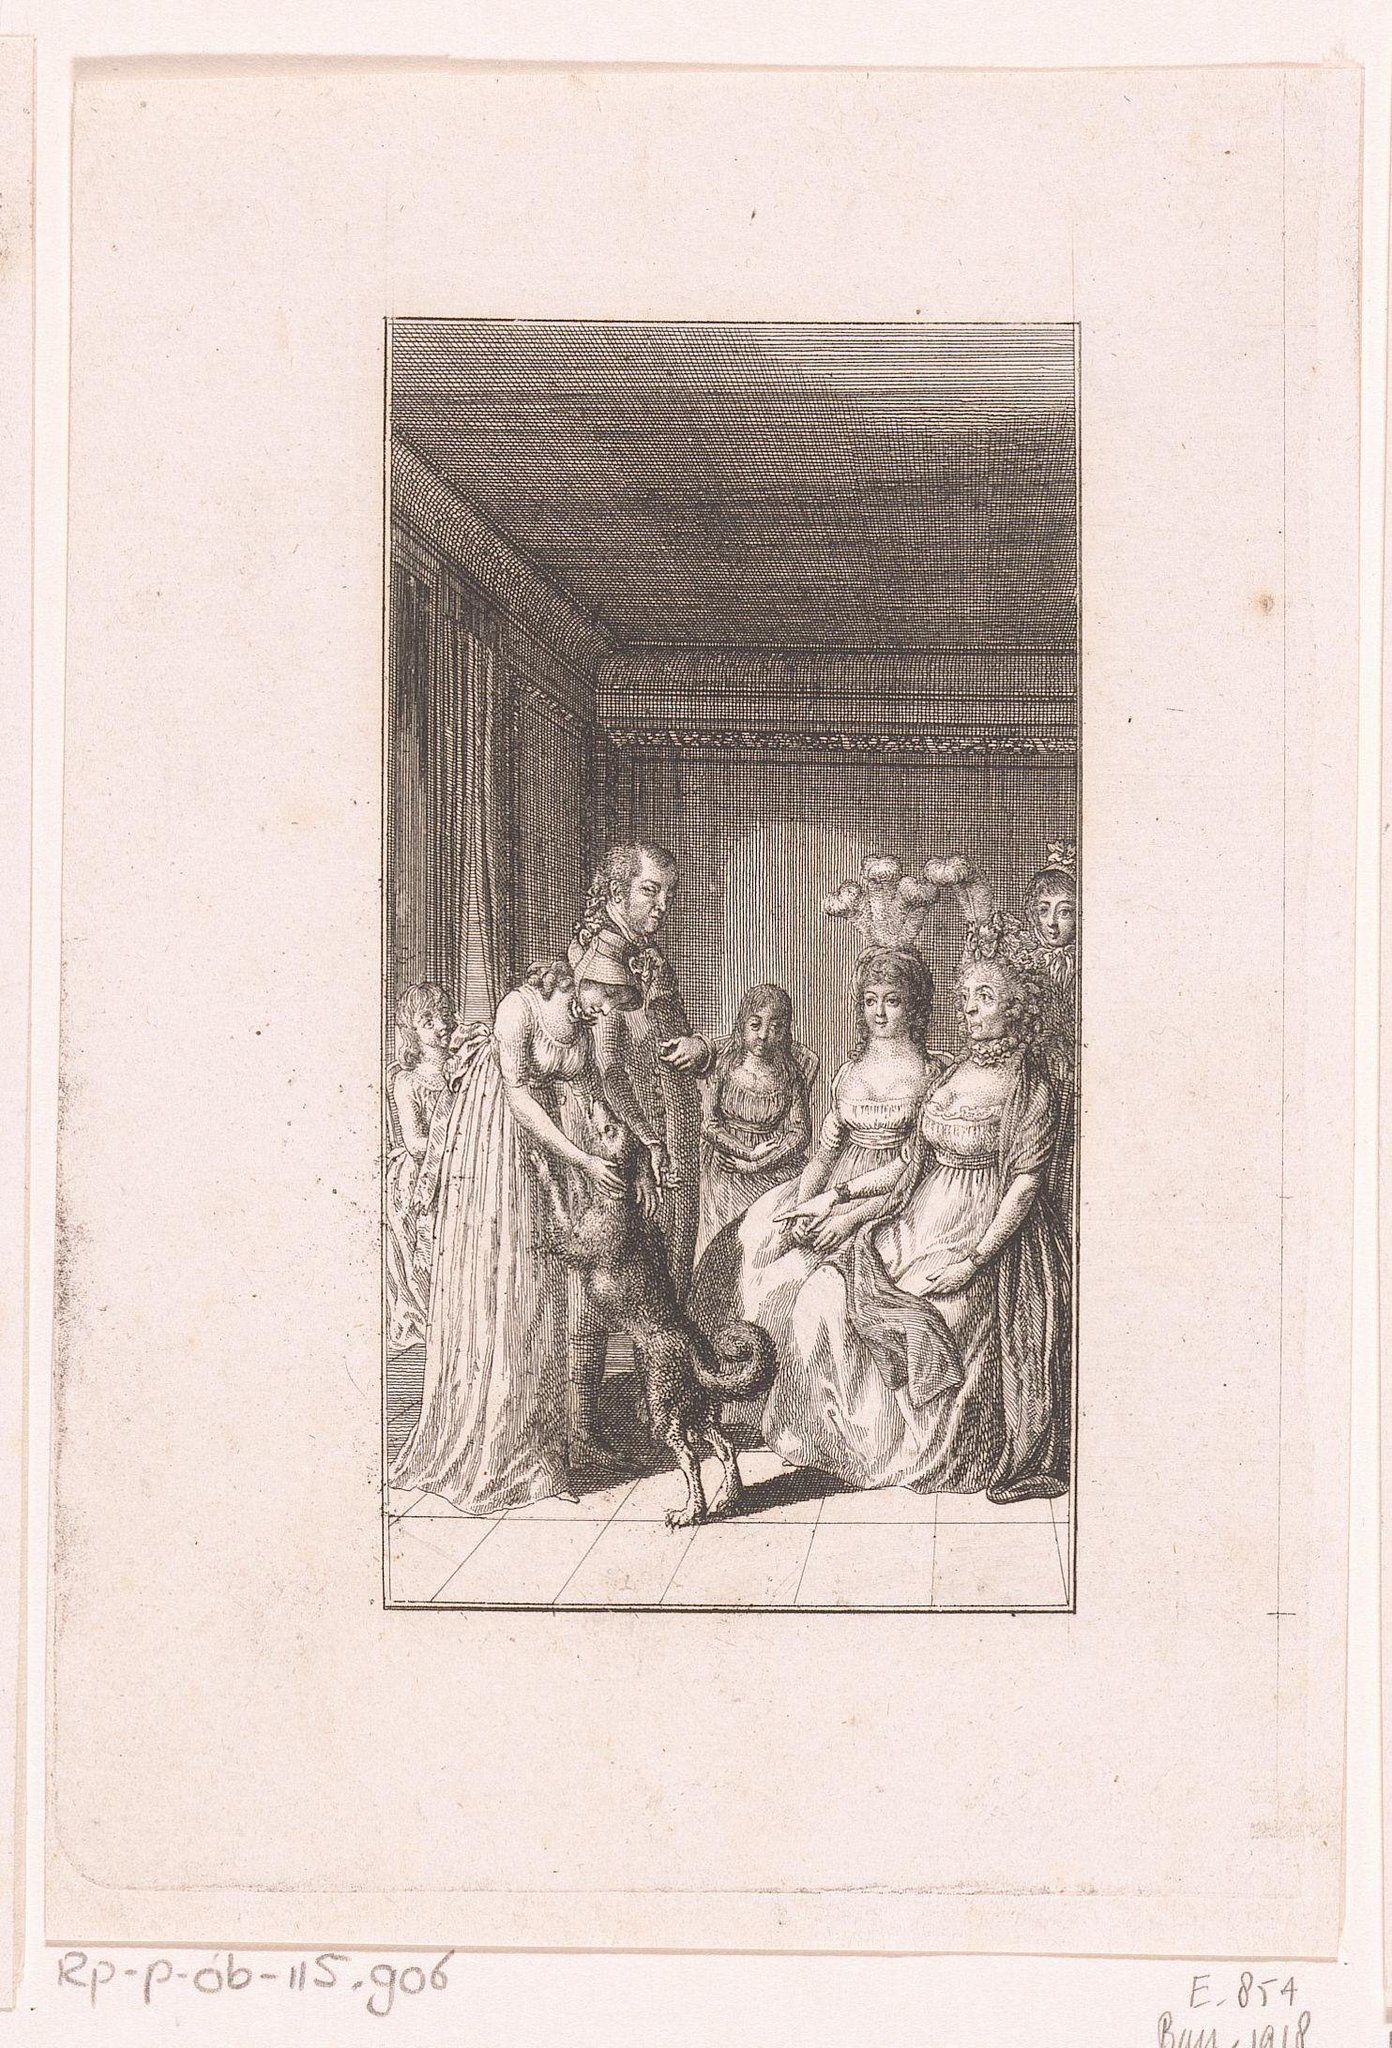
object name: print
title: Thuiskomst van Julchen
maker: daniel nikolaus chodowiecki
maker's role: draughtsman, print maker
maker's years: 1726-1801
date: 1797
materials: paper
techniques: etching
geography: berlin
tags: being welcomed ~ travelling, arrival and return ~ travelling, dog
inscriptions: collector's mark: Lugt 2228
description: Latere staat gebruikt voor: Unger, Friederike Helene. Julchen Grünthal. 2 dln. Berlijn: Johann Friedrich Unger, 1798, dl. 1.